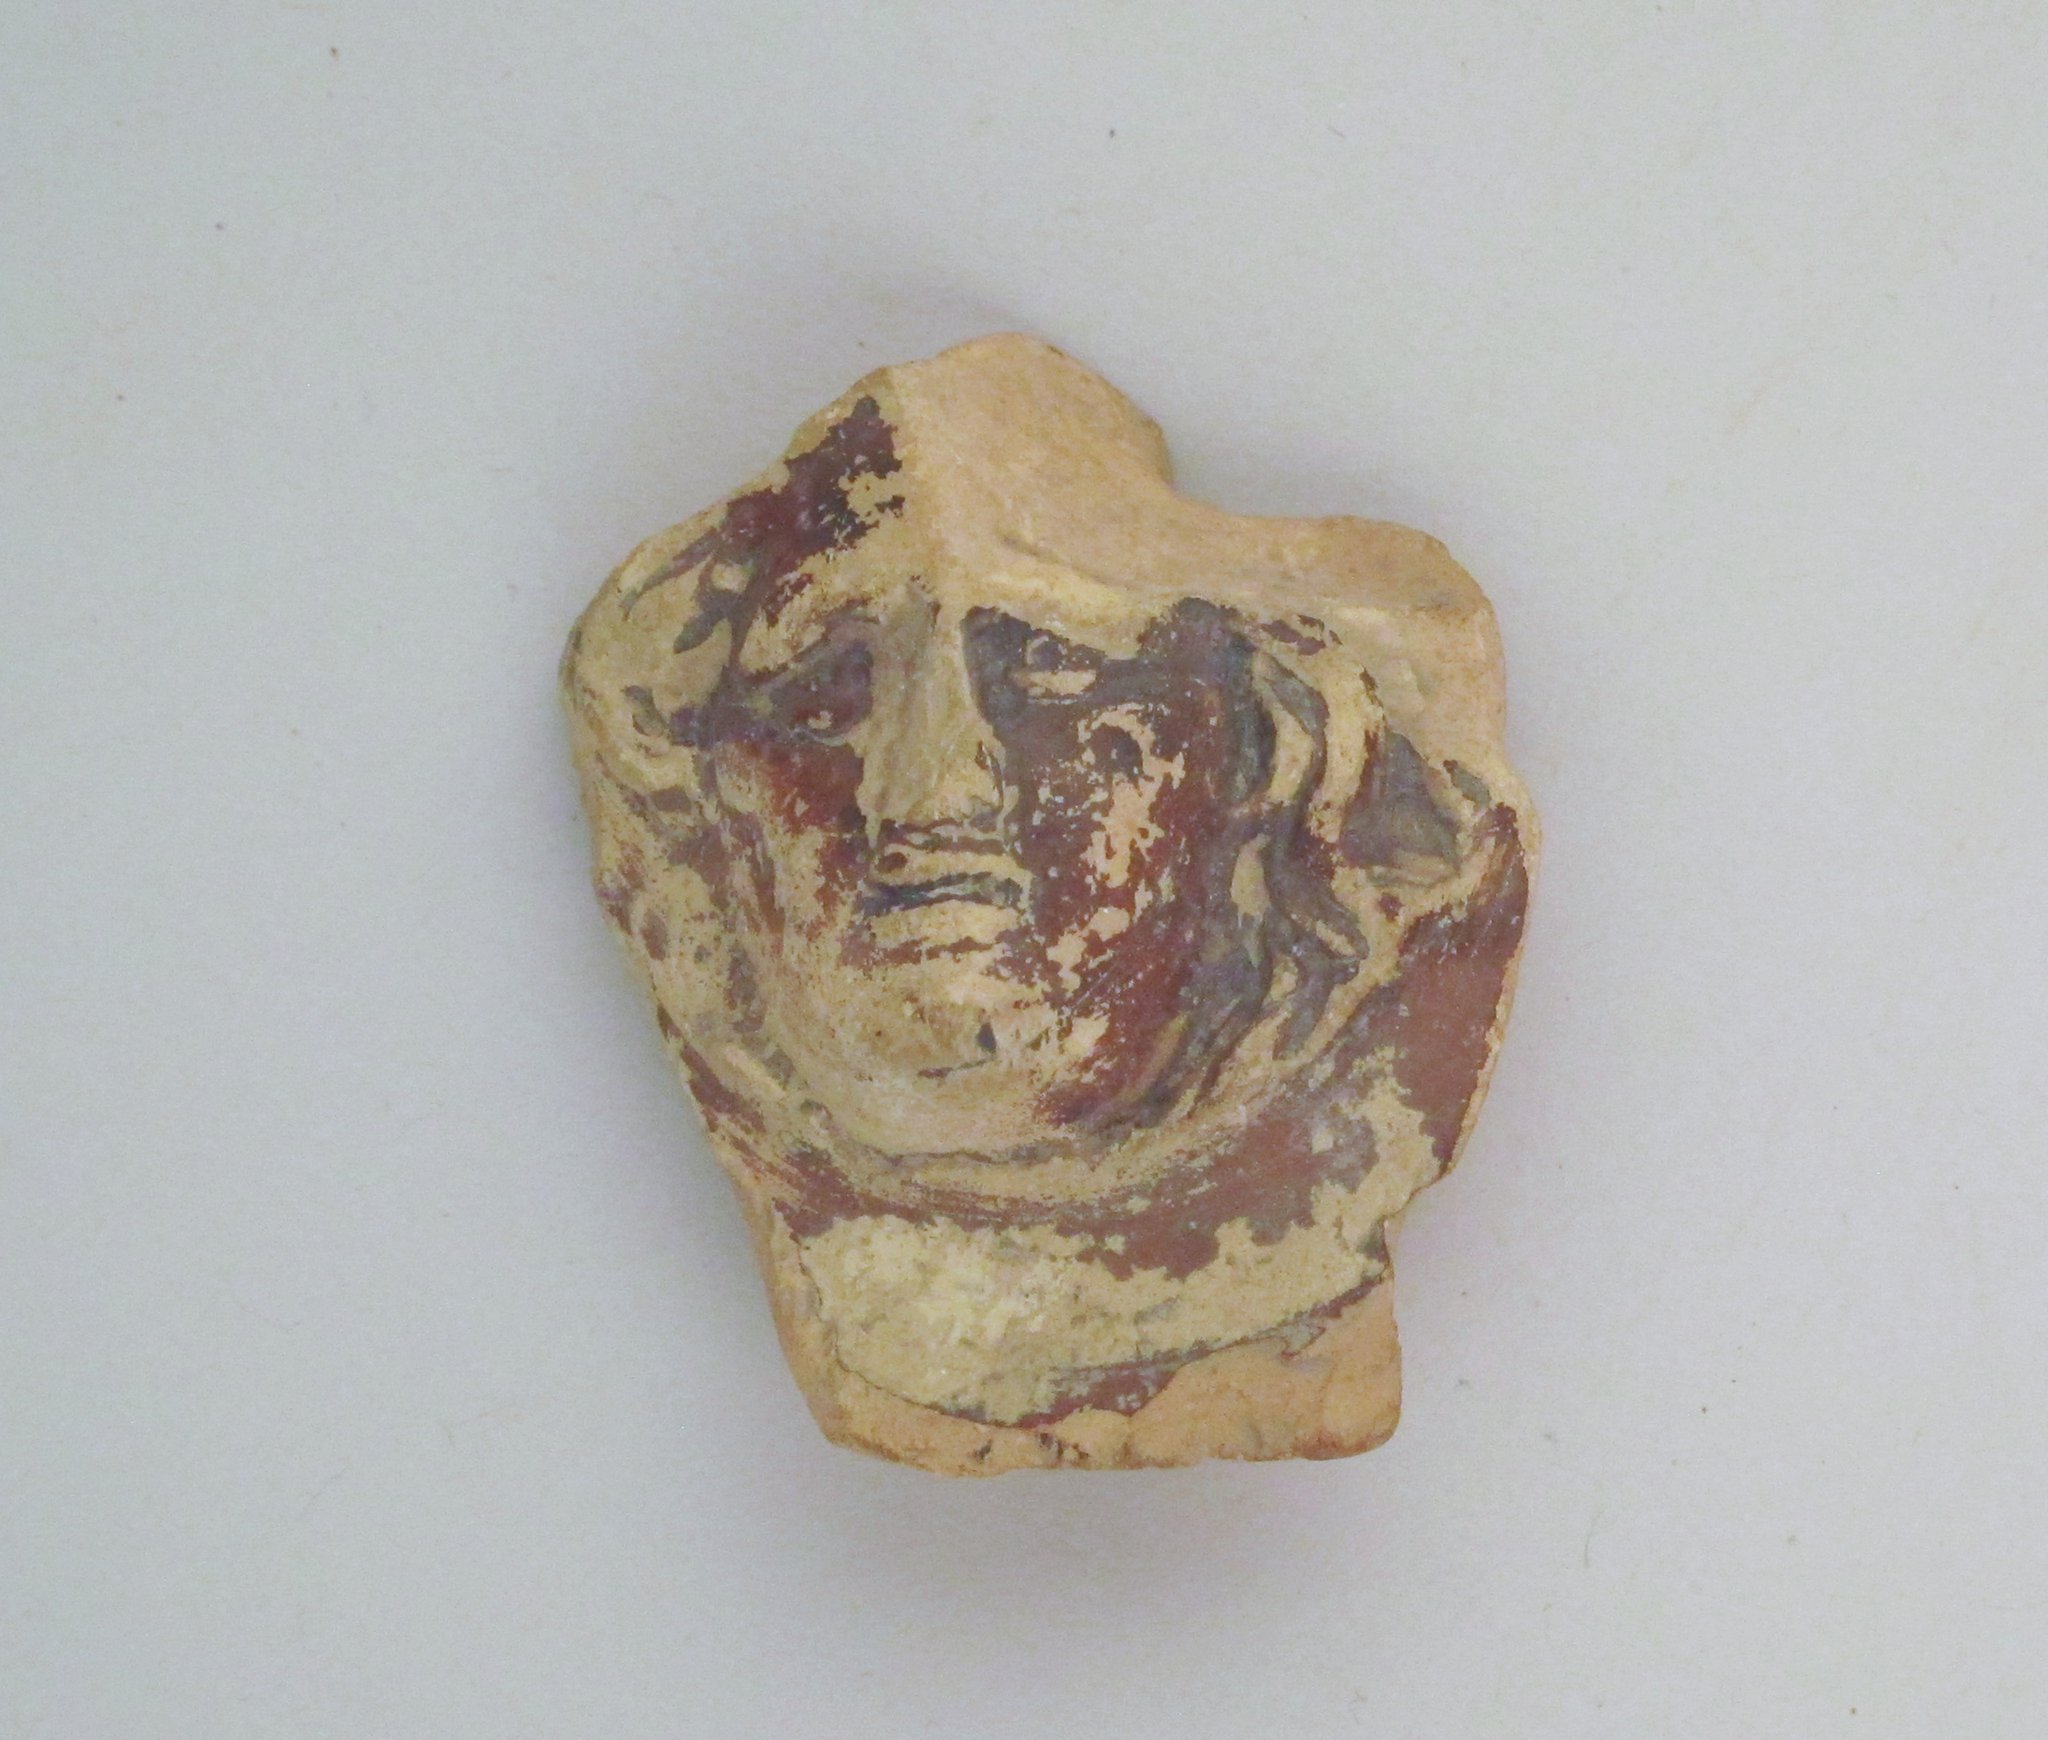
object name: vase fragment in the form of a face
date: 7000 BCE-330 CE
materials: terracotta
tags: faces